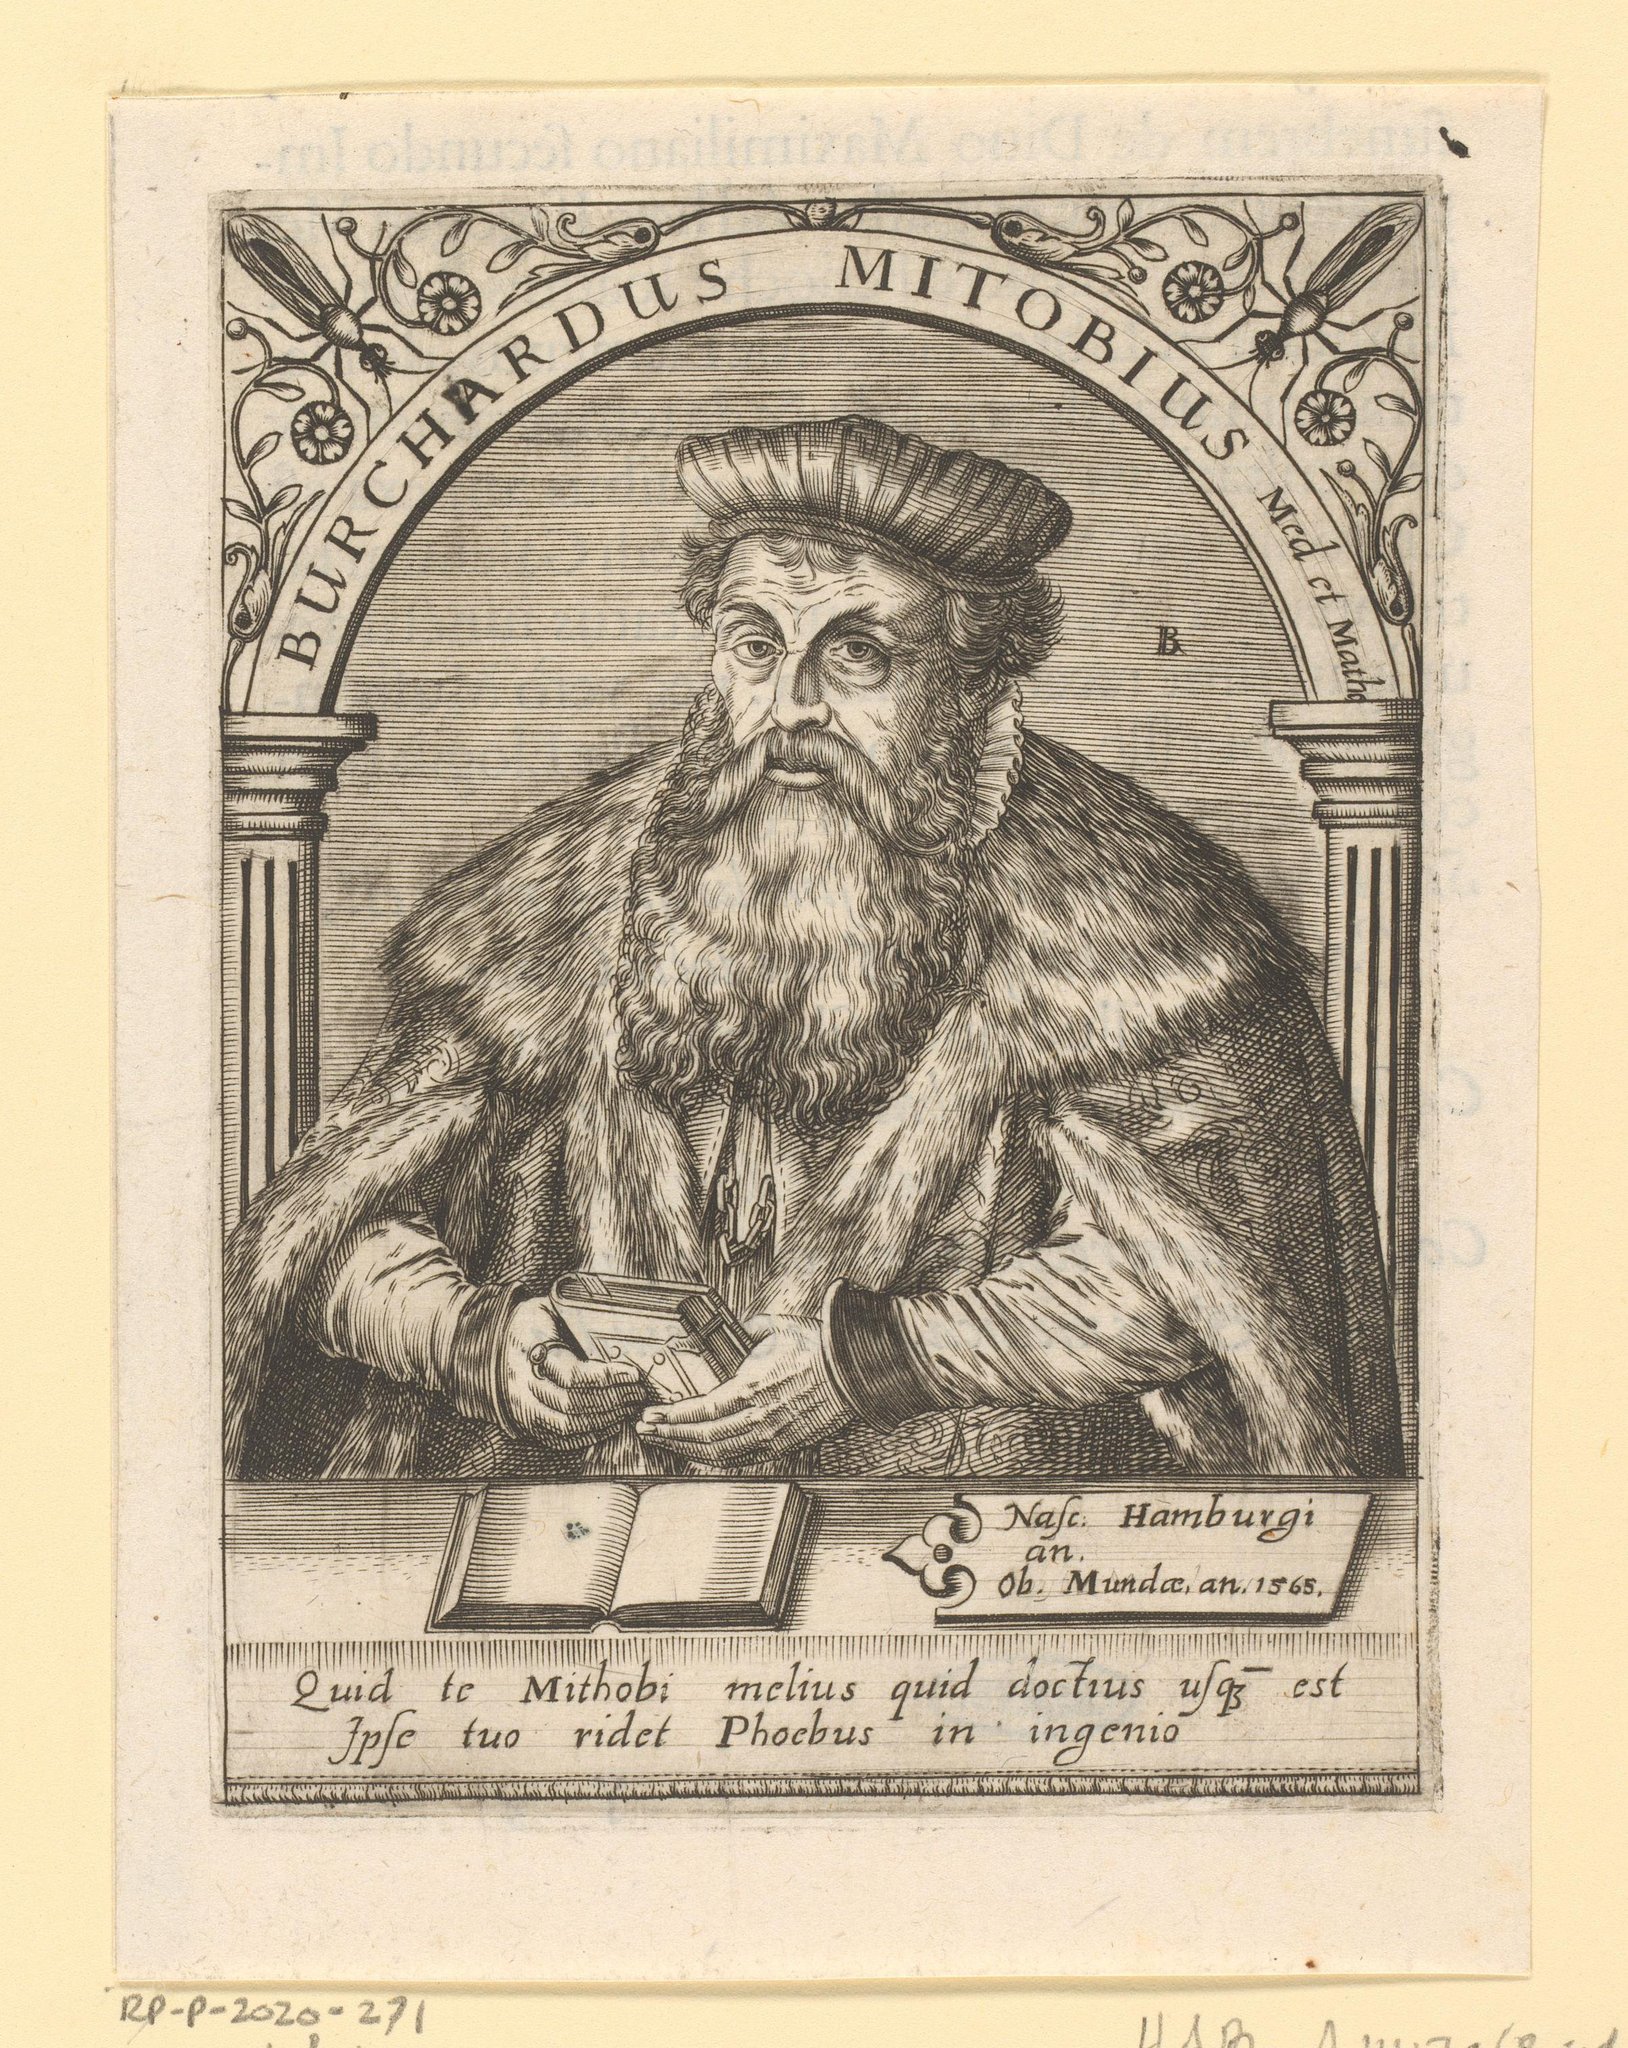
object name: book illustration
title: Portret van Burchard Mithoff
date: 1598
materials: paper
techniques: engraving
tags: historical persons, physician, doctor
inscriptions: collector's mark: Lugt 2228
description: Prent gebruikt in: Boissard, Jean Jacques. Icones quinquaginta virorum illustrium doctrina & eruditione praestantium ad vivum effictae. 4 dln. Frankfurt am Main: s.n., 1597-1599. Mogelijk ook gebruikt in latere edities. Latere staat van prent verschenen in: Boissard, Jean Jacques. Bibliotheca chalcographica. 8 dln. Frankfurt am Main: Johannes Ammon, 1650-1652. Ook gebruikt in latere edities.